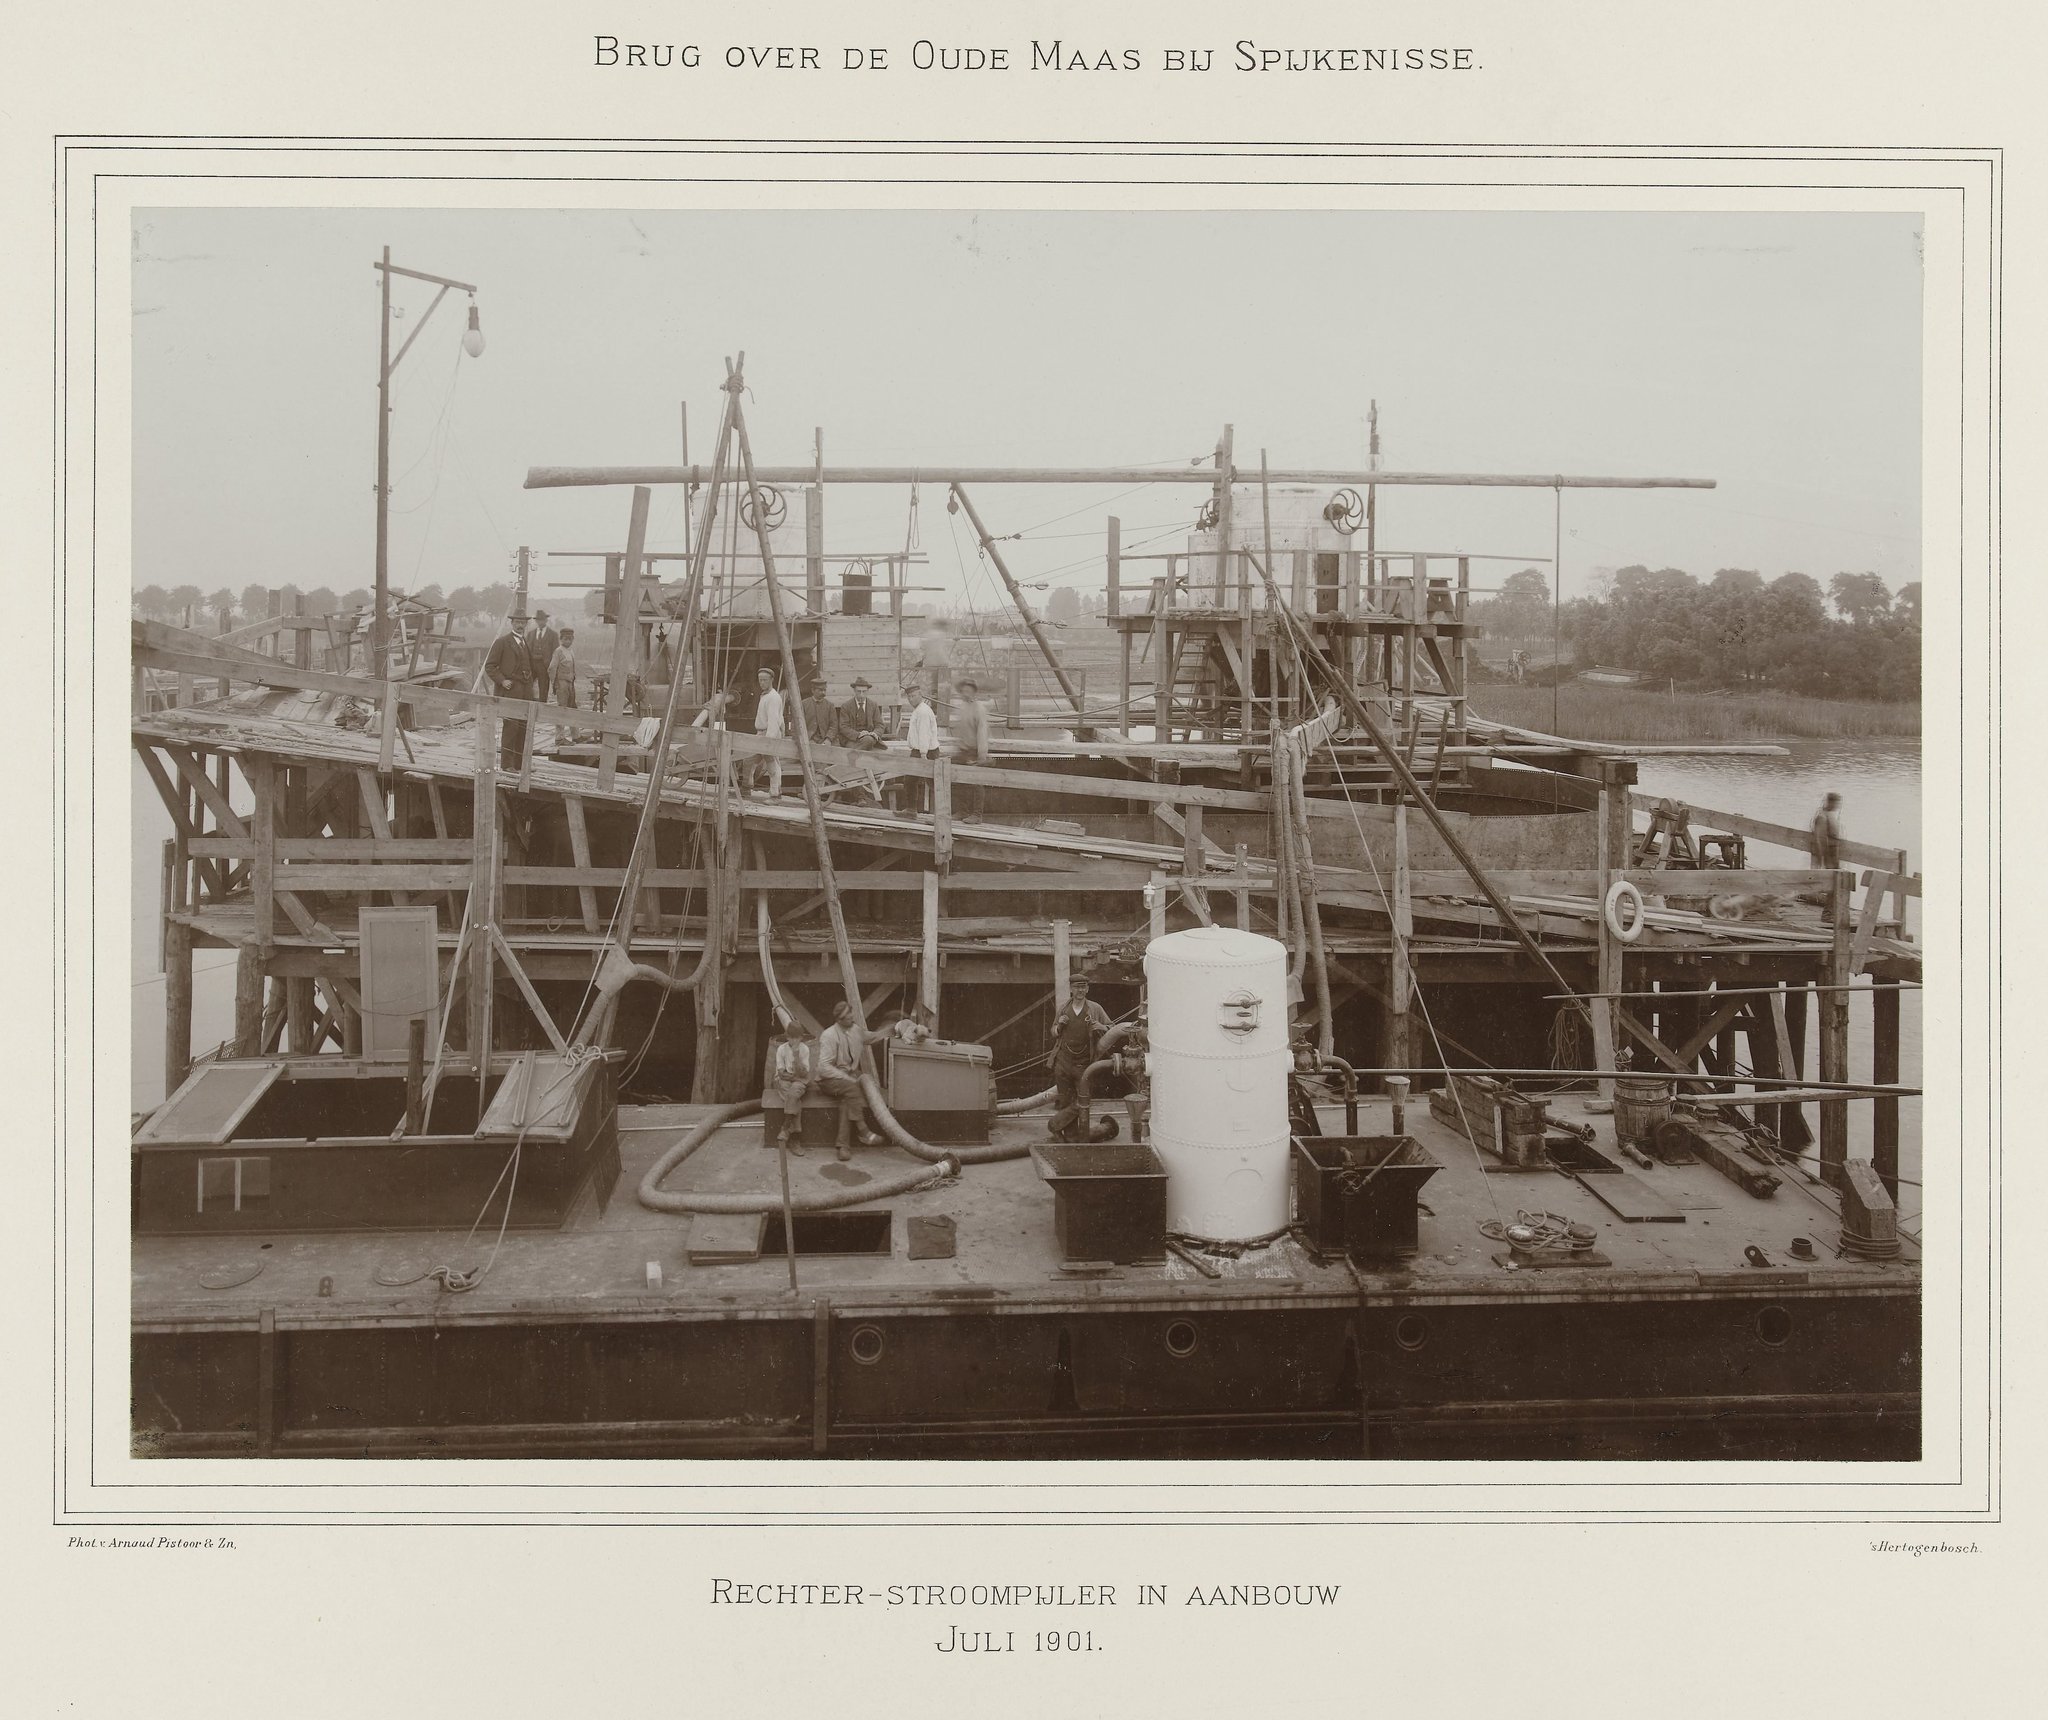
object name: photograph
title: Brug over de Oude Maas bij Spijkenisse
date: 1901-1907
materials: cardboard, photographic support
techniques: collodion silver print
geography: den bosch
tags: bridge, building-site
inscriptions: date